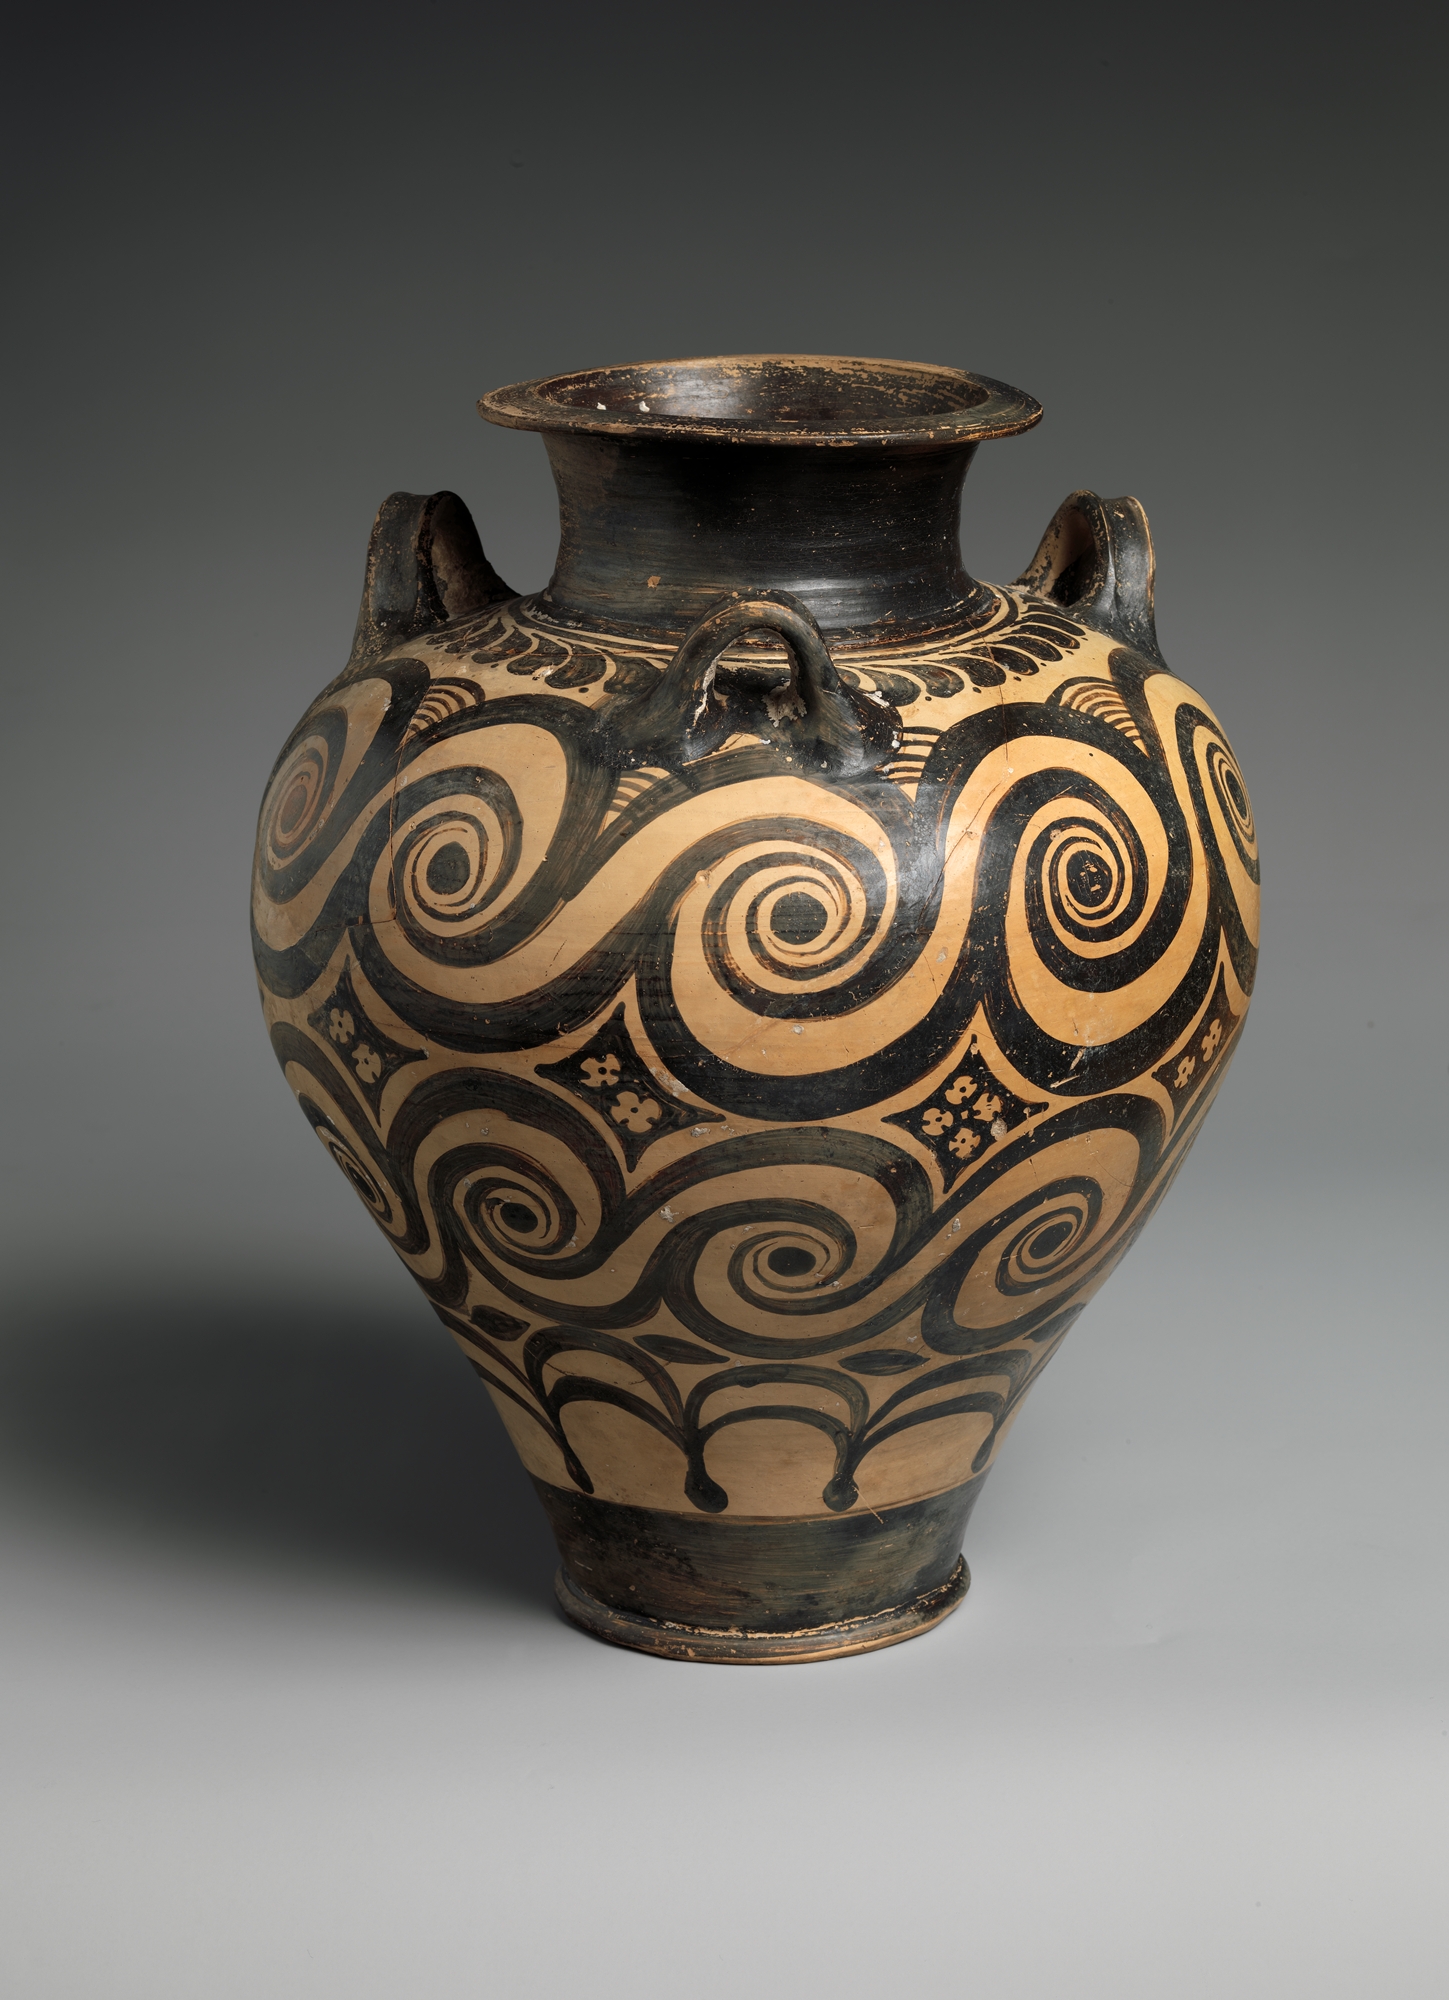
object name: pithoid jar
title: Terracotta jar with three handles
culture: minoan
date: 1525-1490 BCE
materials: terracotta